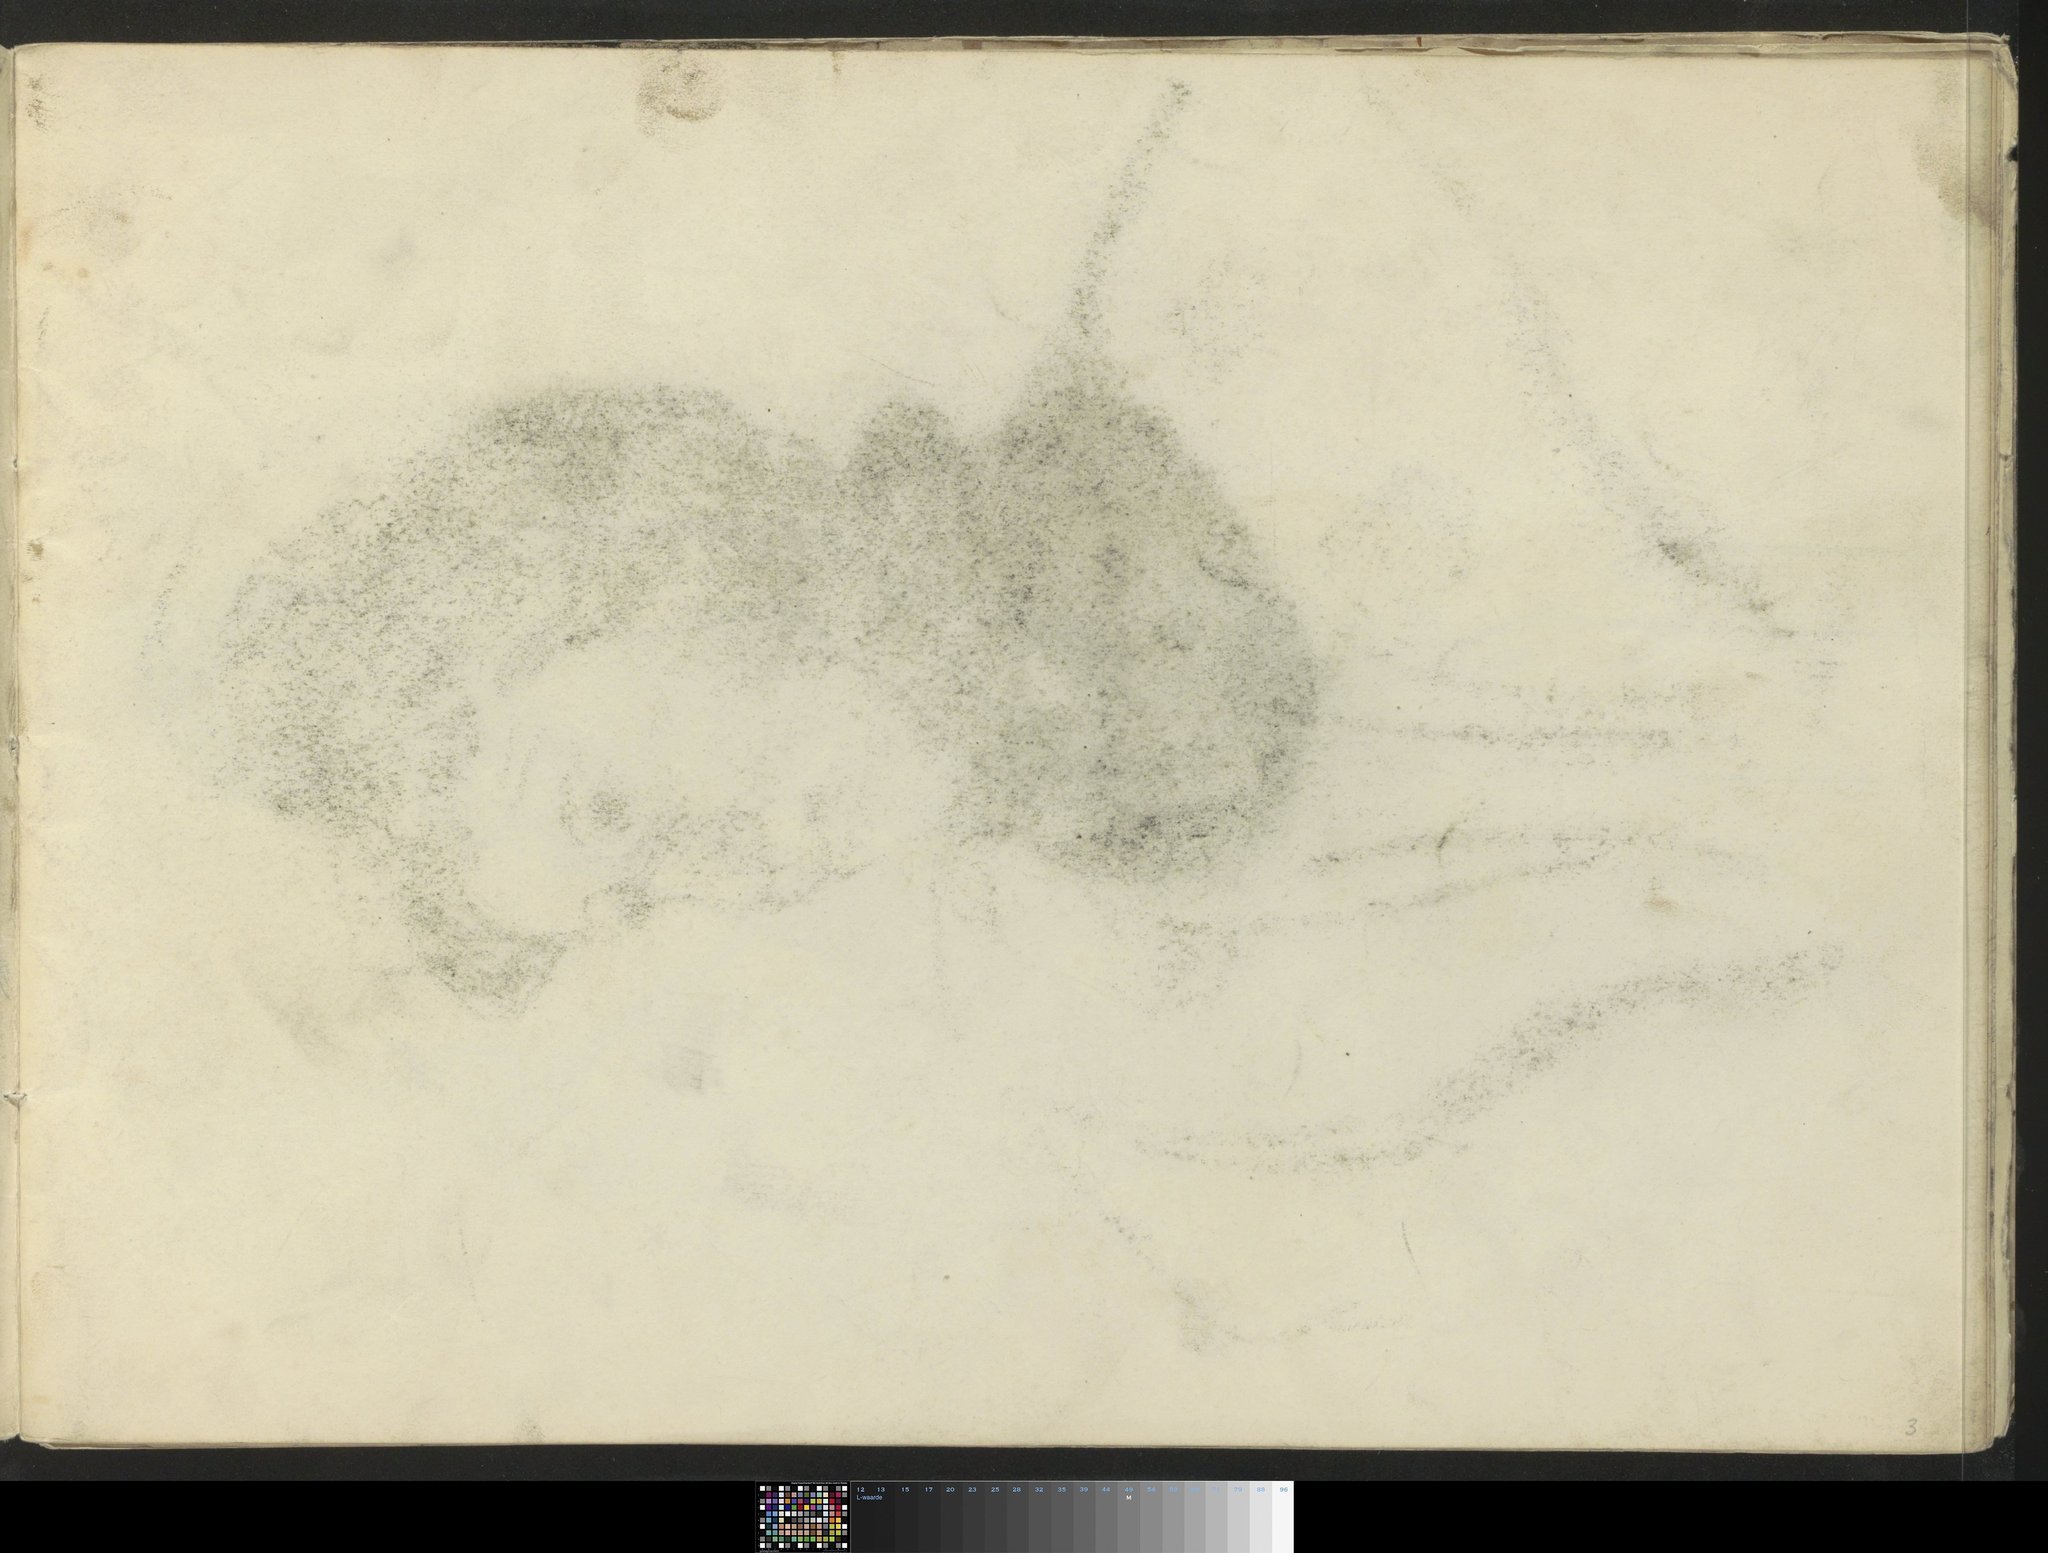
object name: sketchbook leaf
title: Abklatsch van de krijttekening op blad 2 verso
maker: isaac israels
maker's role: draughtsman, painter, print maker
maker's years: 1865-1934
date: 1875-1934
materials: paper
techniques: printmaking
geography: the hague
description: Blad 3 recto uit schetsboek XII met 19 bladen.